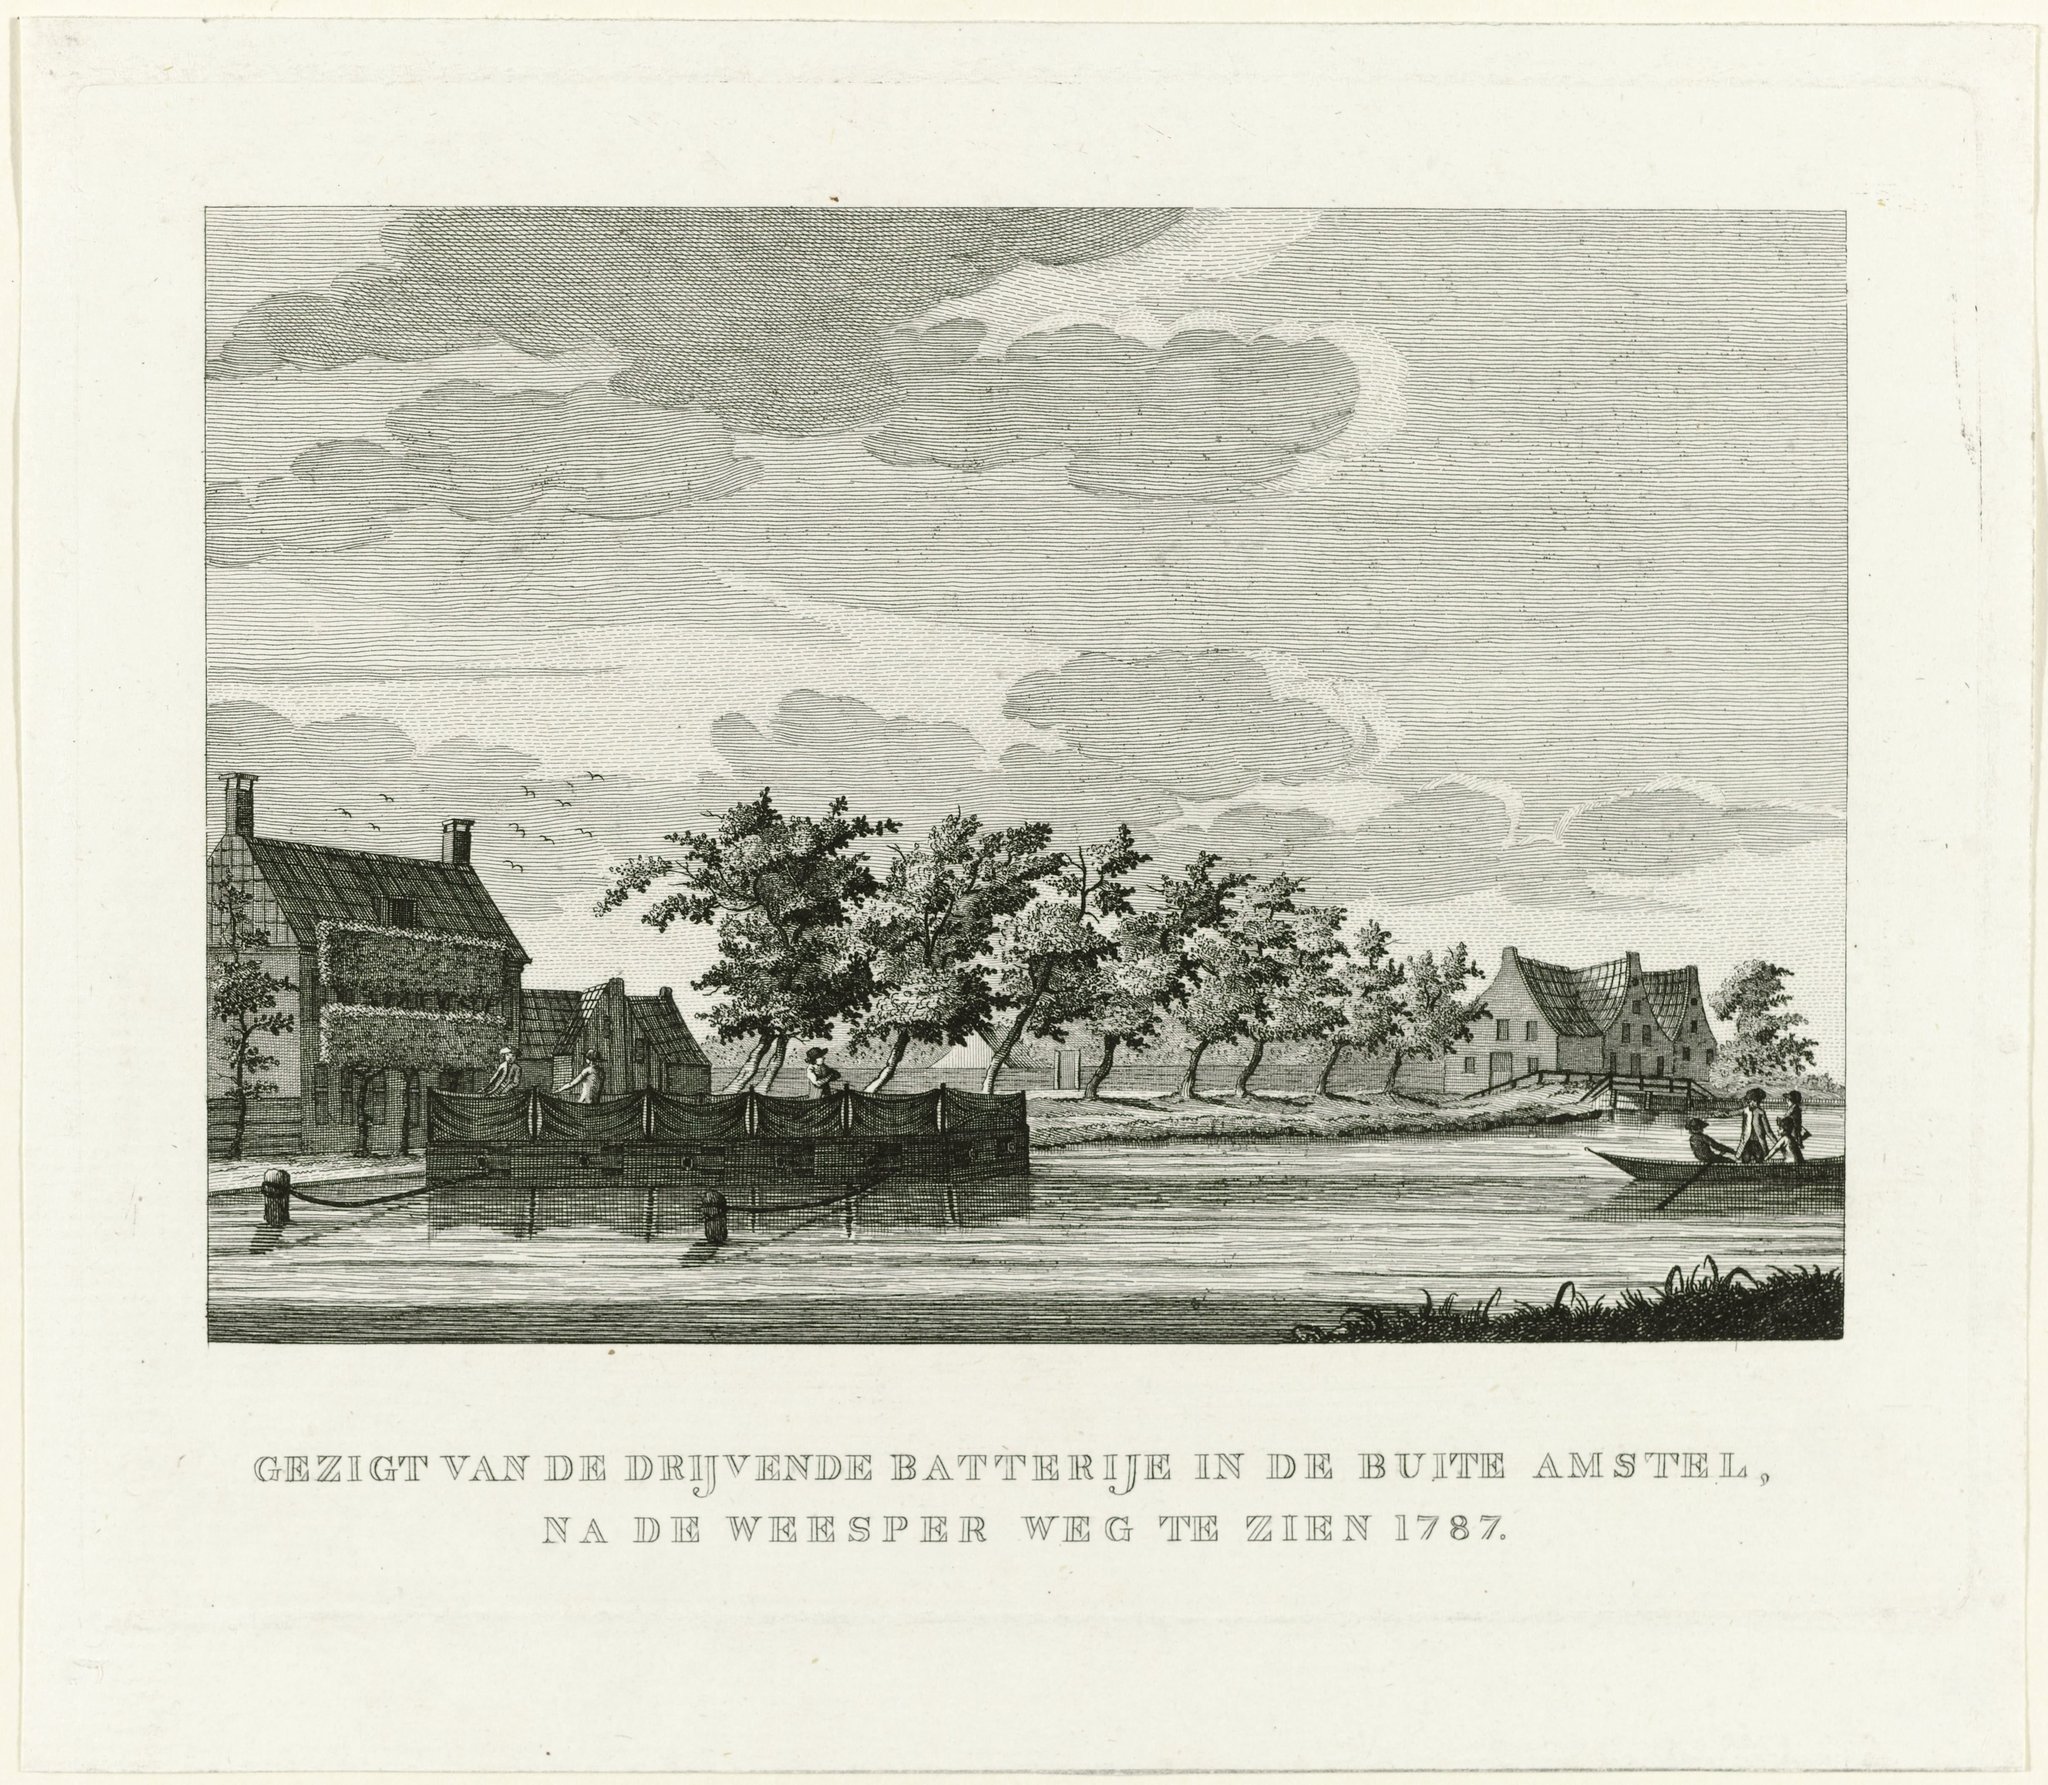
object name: print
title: Batterijen rondom Amsterdam in 1787 (kopieën)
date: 1787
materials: paper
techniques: engraving, etching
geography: northern netherlands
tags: defence of fortification or city, defensive measures (military)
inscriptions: collector's mark: Lugt 2228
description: Drijvende batterij in de Amstel aan de Weesperzijde, ten hoogte van de Weesperweg. Onderdeel van een serie van veertien platen (waarvan de dertiende prent ontbreekt), gekopieerd naar de eerste reeks van platen van de verdedigingen aangelegd door de patriotten rondom Amsterdam ten tijde van de inval van de Pruisische troepen in september 1787.